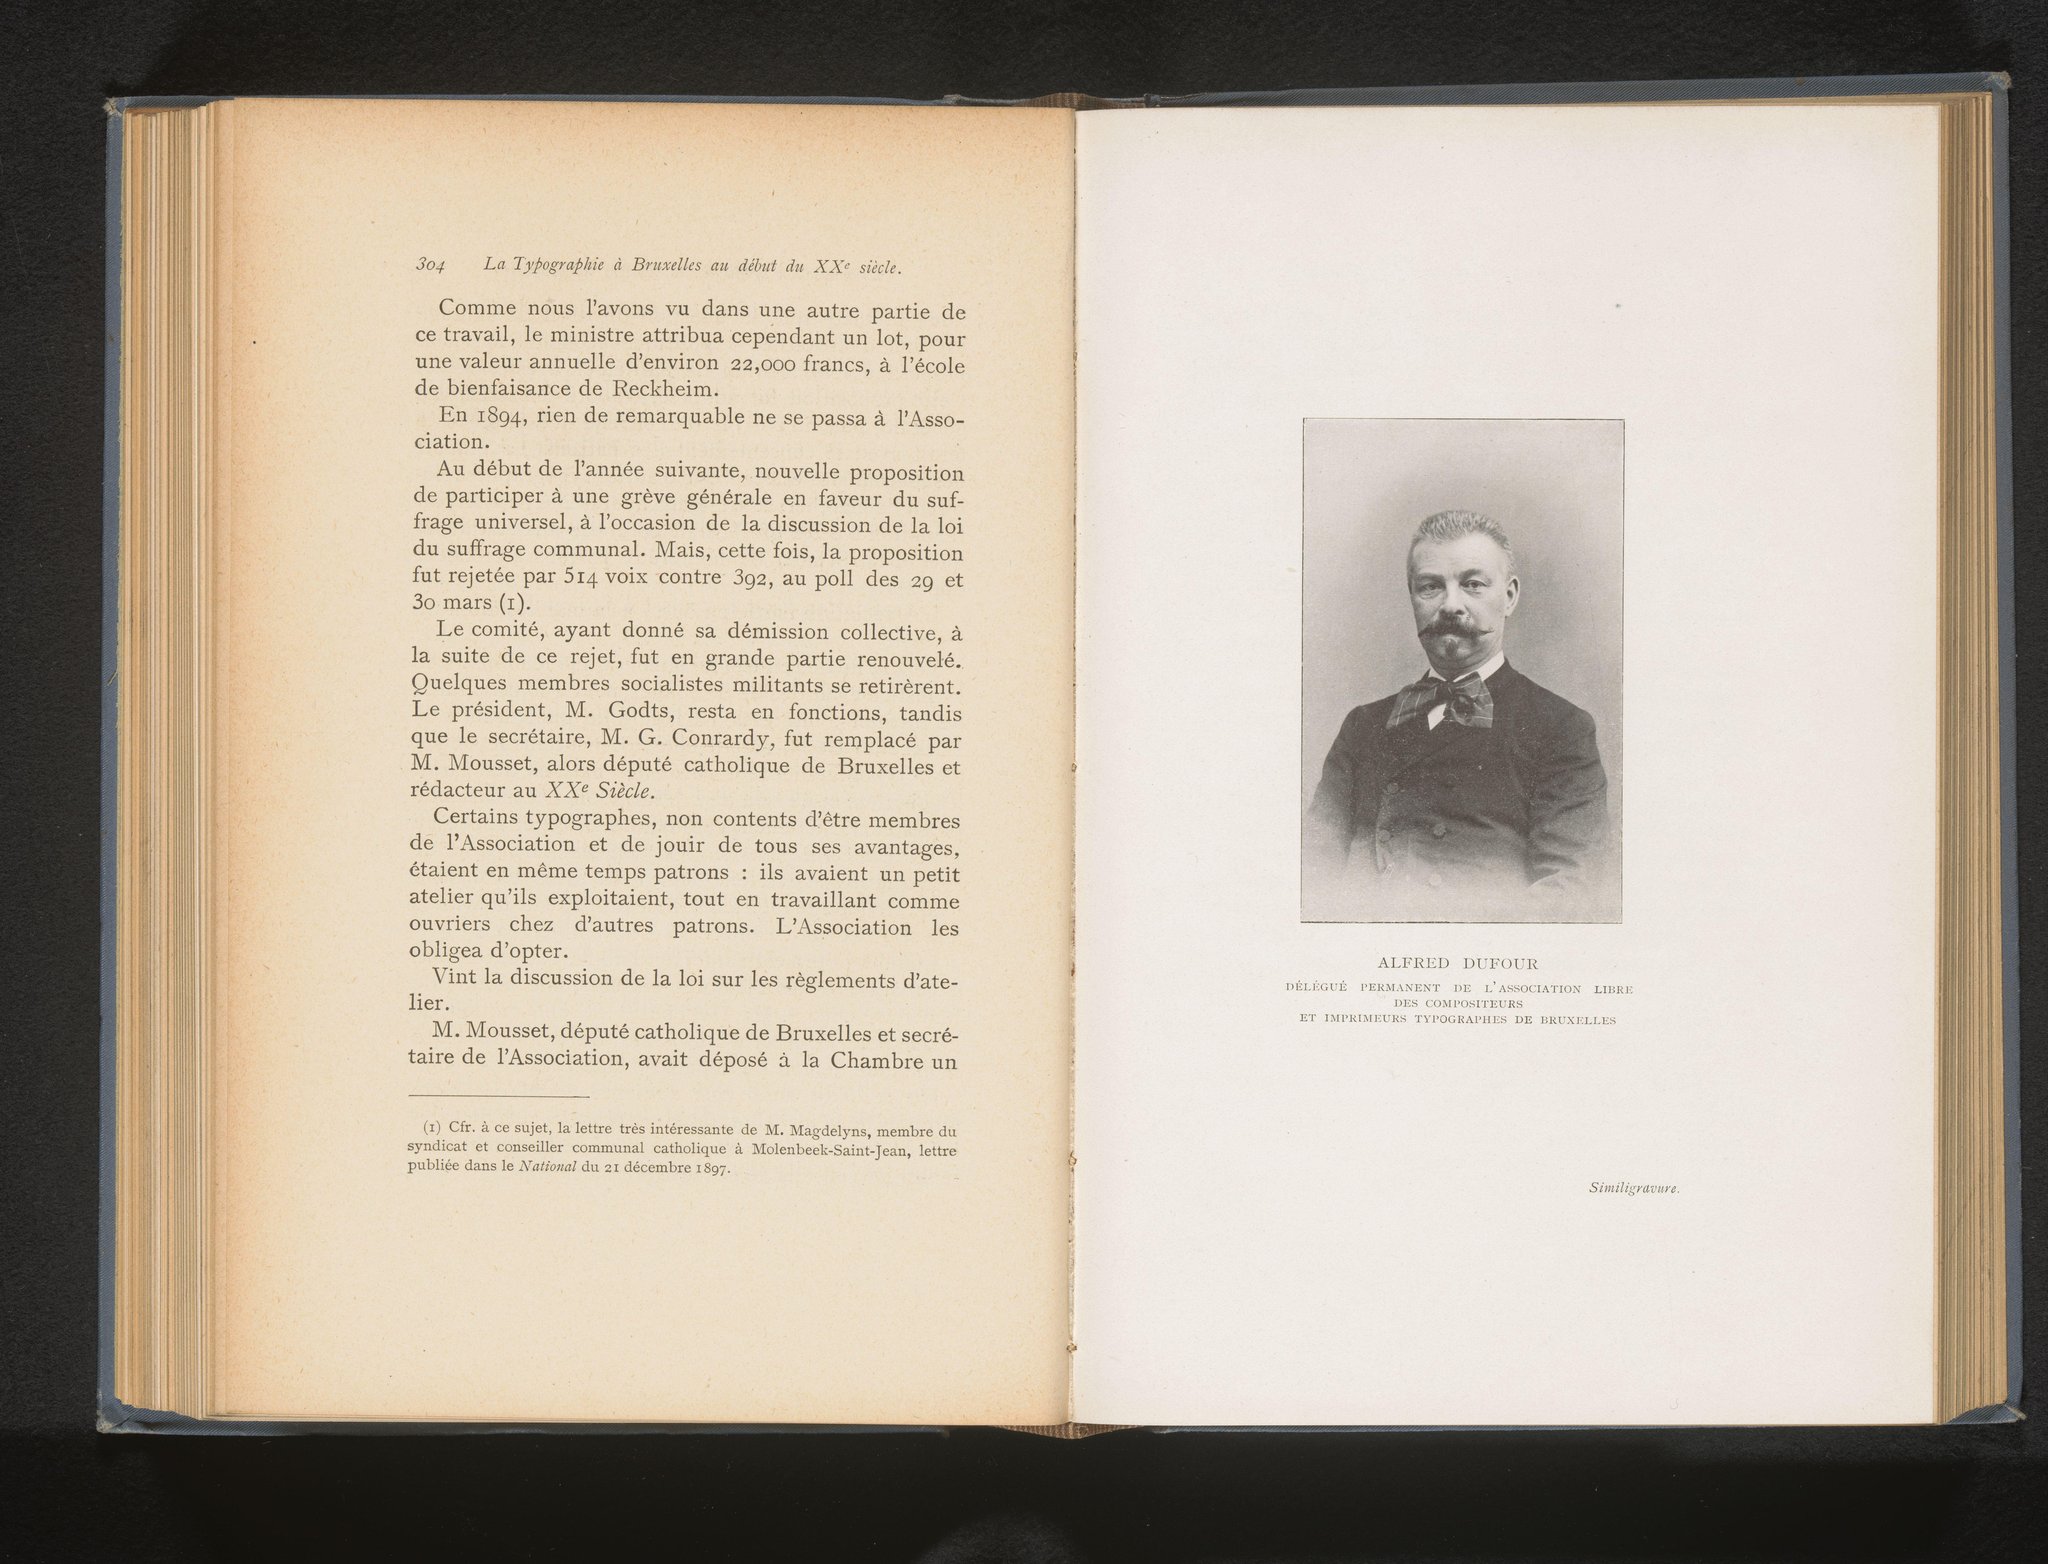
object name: photomechanical print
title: Portret van Alfred Dufour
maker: Anonymous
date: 1899-1904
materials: paper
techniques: autotype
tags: historical persons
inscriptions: inscription: ‘Similigravure.’, inscription: ‘Délégué permanent de l'association libre/ des compositeurs/ et imprimeurs typographes de Bruxelles’